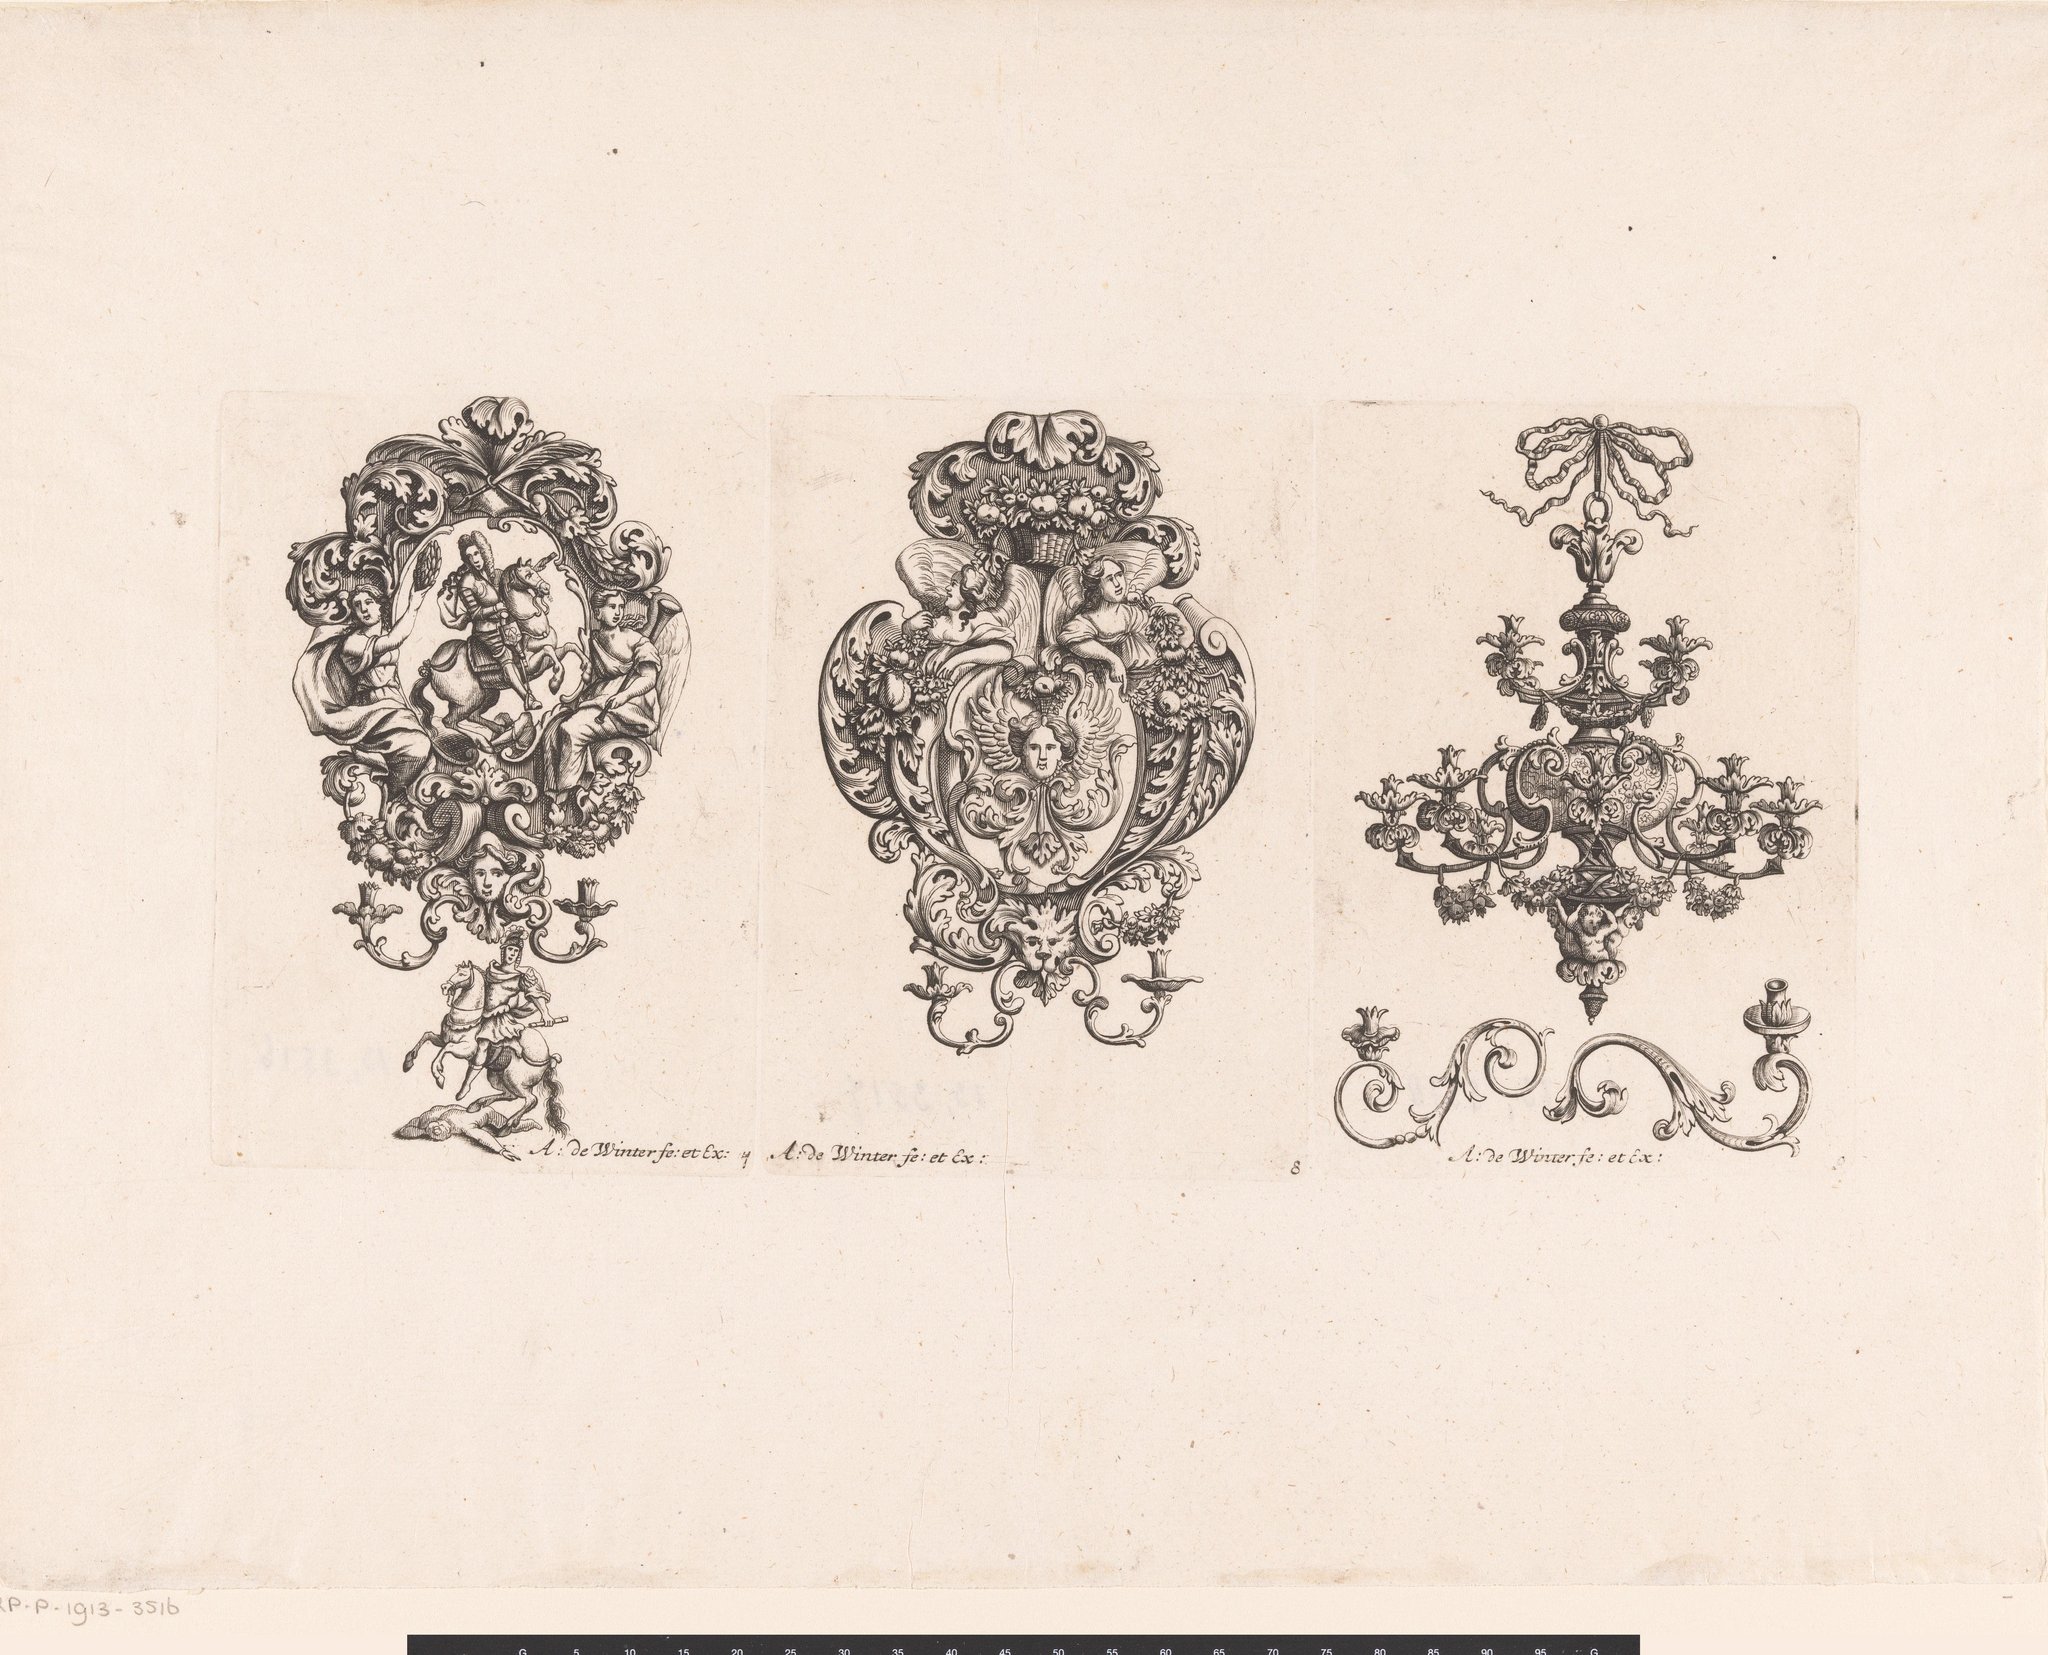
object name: print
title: Nieuwe Hang-blakers en Kerckroonen (...)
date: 1696-1717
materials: paper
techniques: engraving, etching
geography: amsterdam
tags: riding a horse, ass, or mule; rider, horseman, cherubs, i.e. children's heads with wings, chandelier, candelabrum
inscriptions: collector's mark: Lugt 2228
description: Drie prenten op een blad. Links: Een tweearmige wandkandelaar met een man te paard en twee vrouwen. Midden: Een wandkandelaar met twee engelen en een cherubijn. Rechts: Een kroonluchter met twee lagen met bladmotieven.